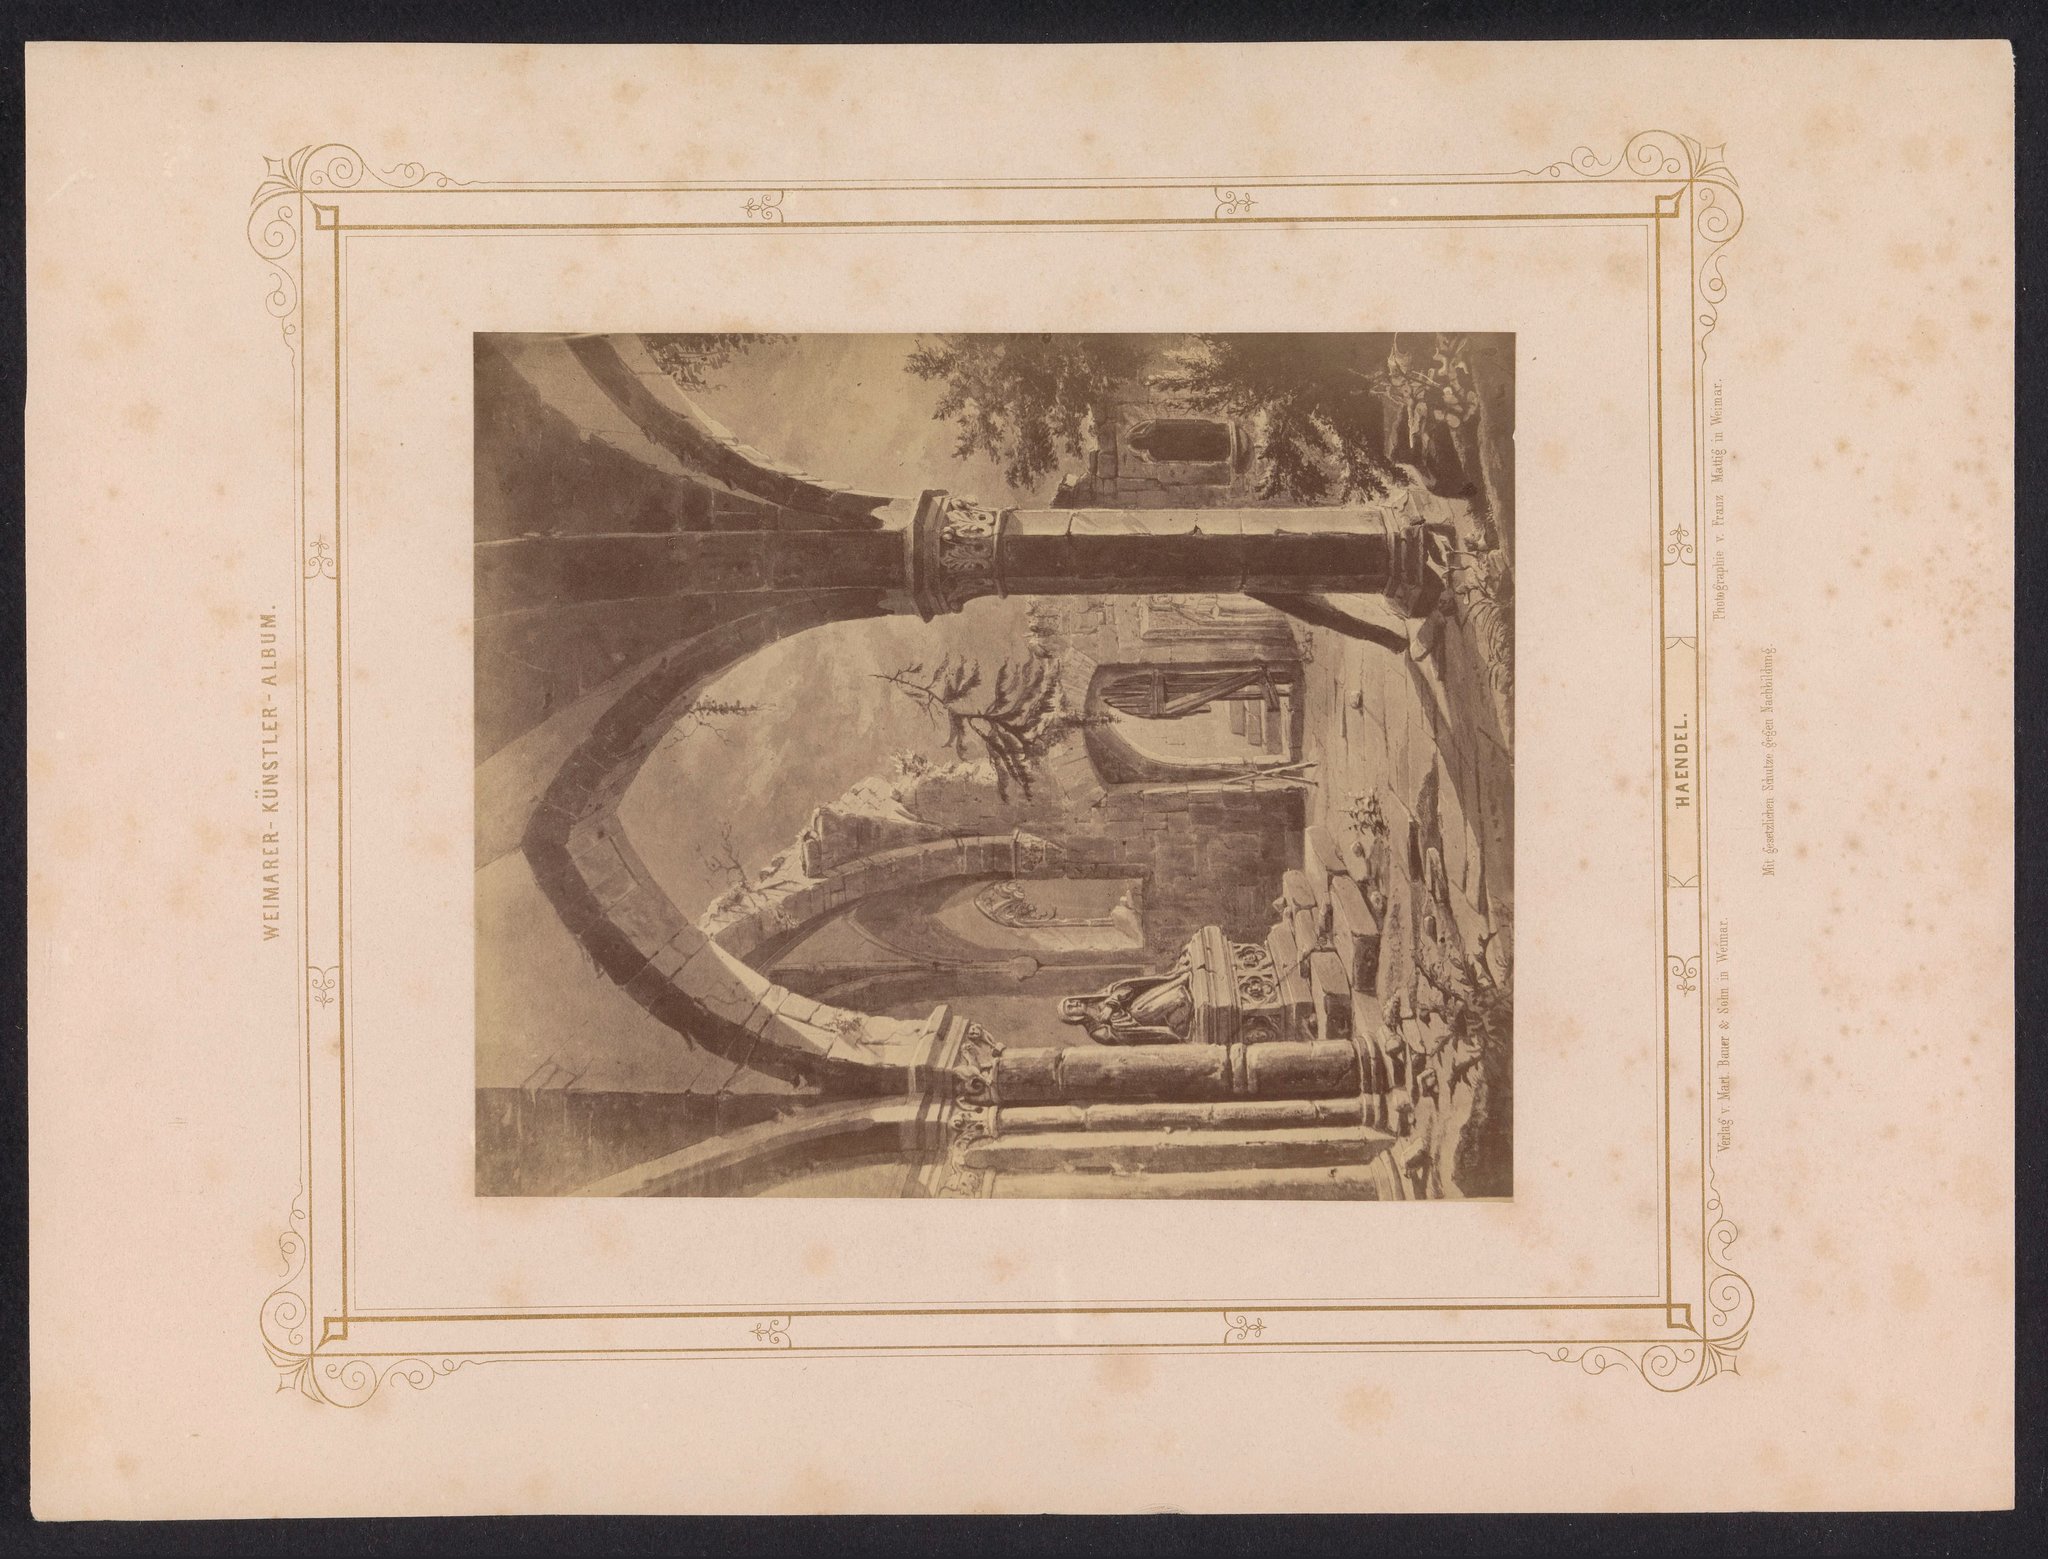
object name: page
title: Fotoreproductie van een tekening, voorstellende de ruïne van een kerk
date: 1854-1859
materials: photographic support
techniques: albumen print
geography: weimar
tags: ruin of church, monastery, etc.